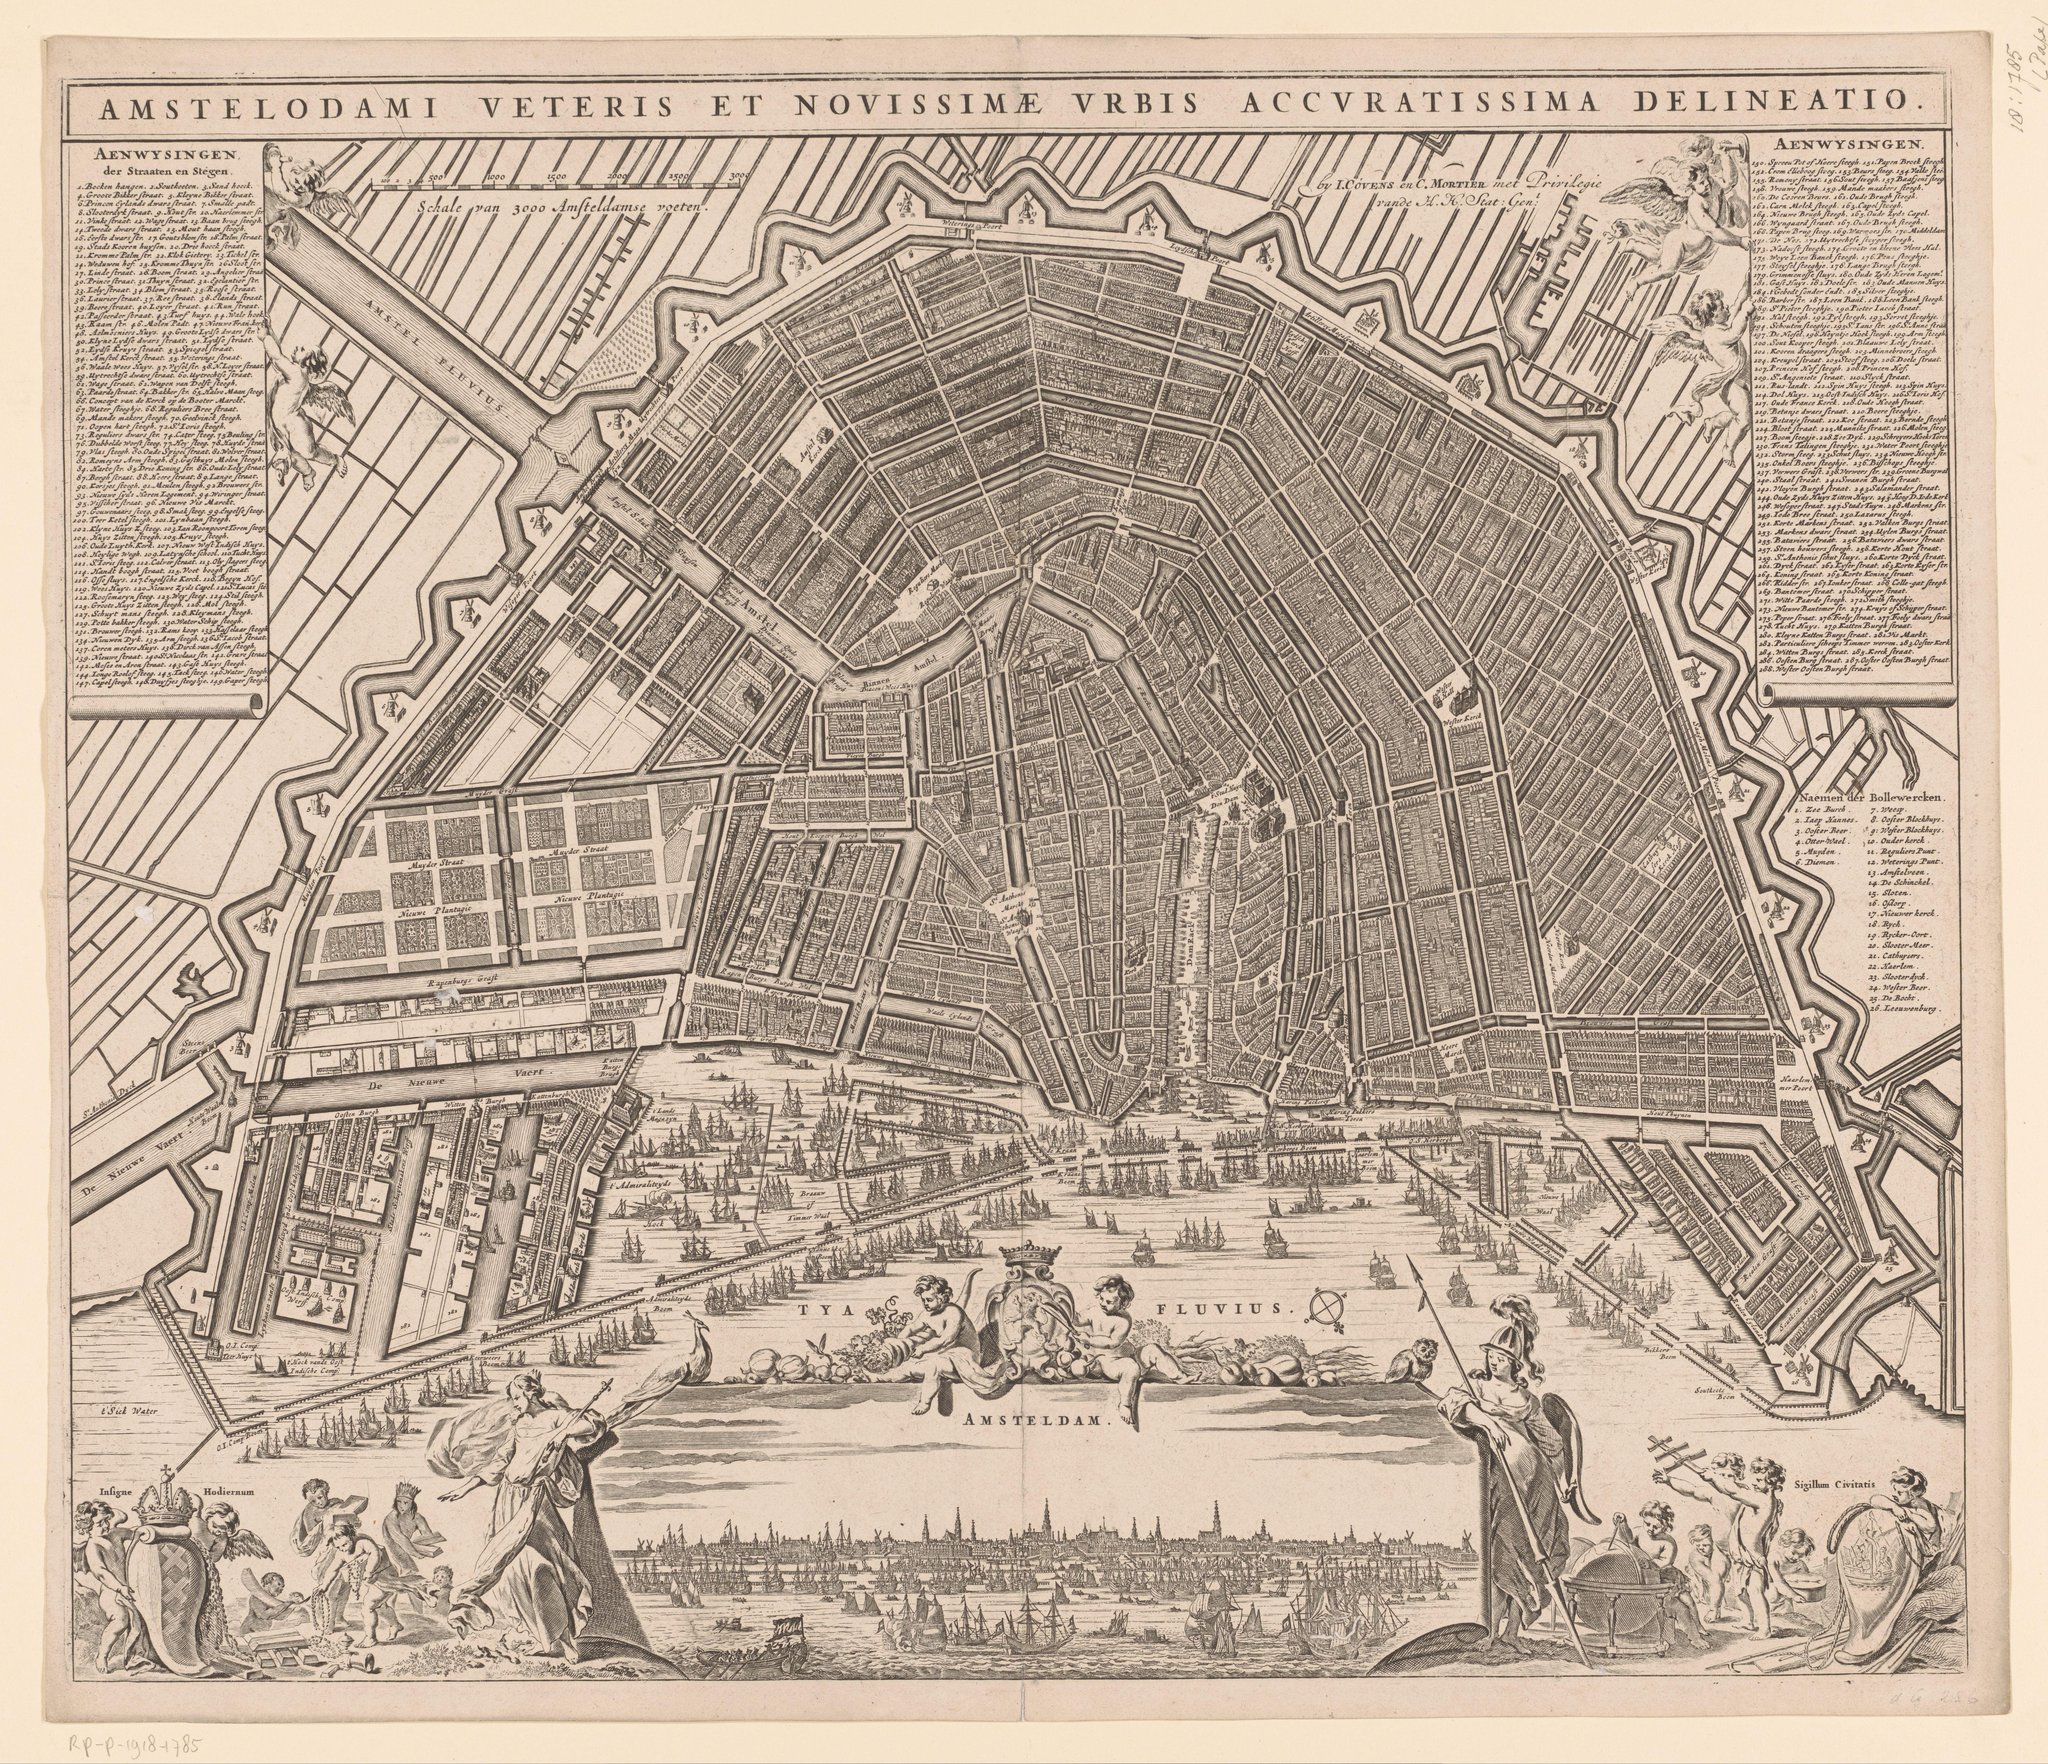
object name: print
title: Plattegrond van Amsterdam met stadsgezicht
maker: Anonymous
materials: paper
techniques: engraving, etching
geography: amsterdam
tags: maps of cities, prospect of city, town panorama, silhouette of city, amsterdam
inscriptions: collector's mark: Lugt 2233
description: De eerste staat van deze plattegrond werd rond 1662 uitgegeven door Nicolaes Visscher en daarna steeds aangepast.